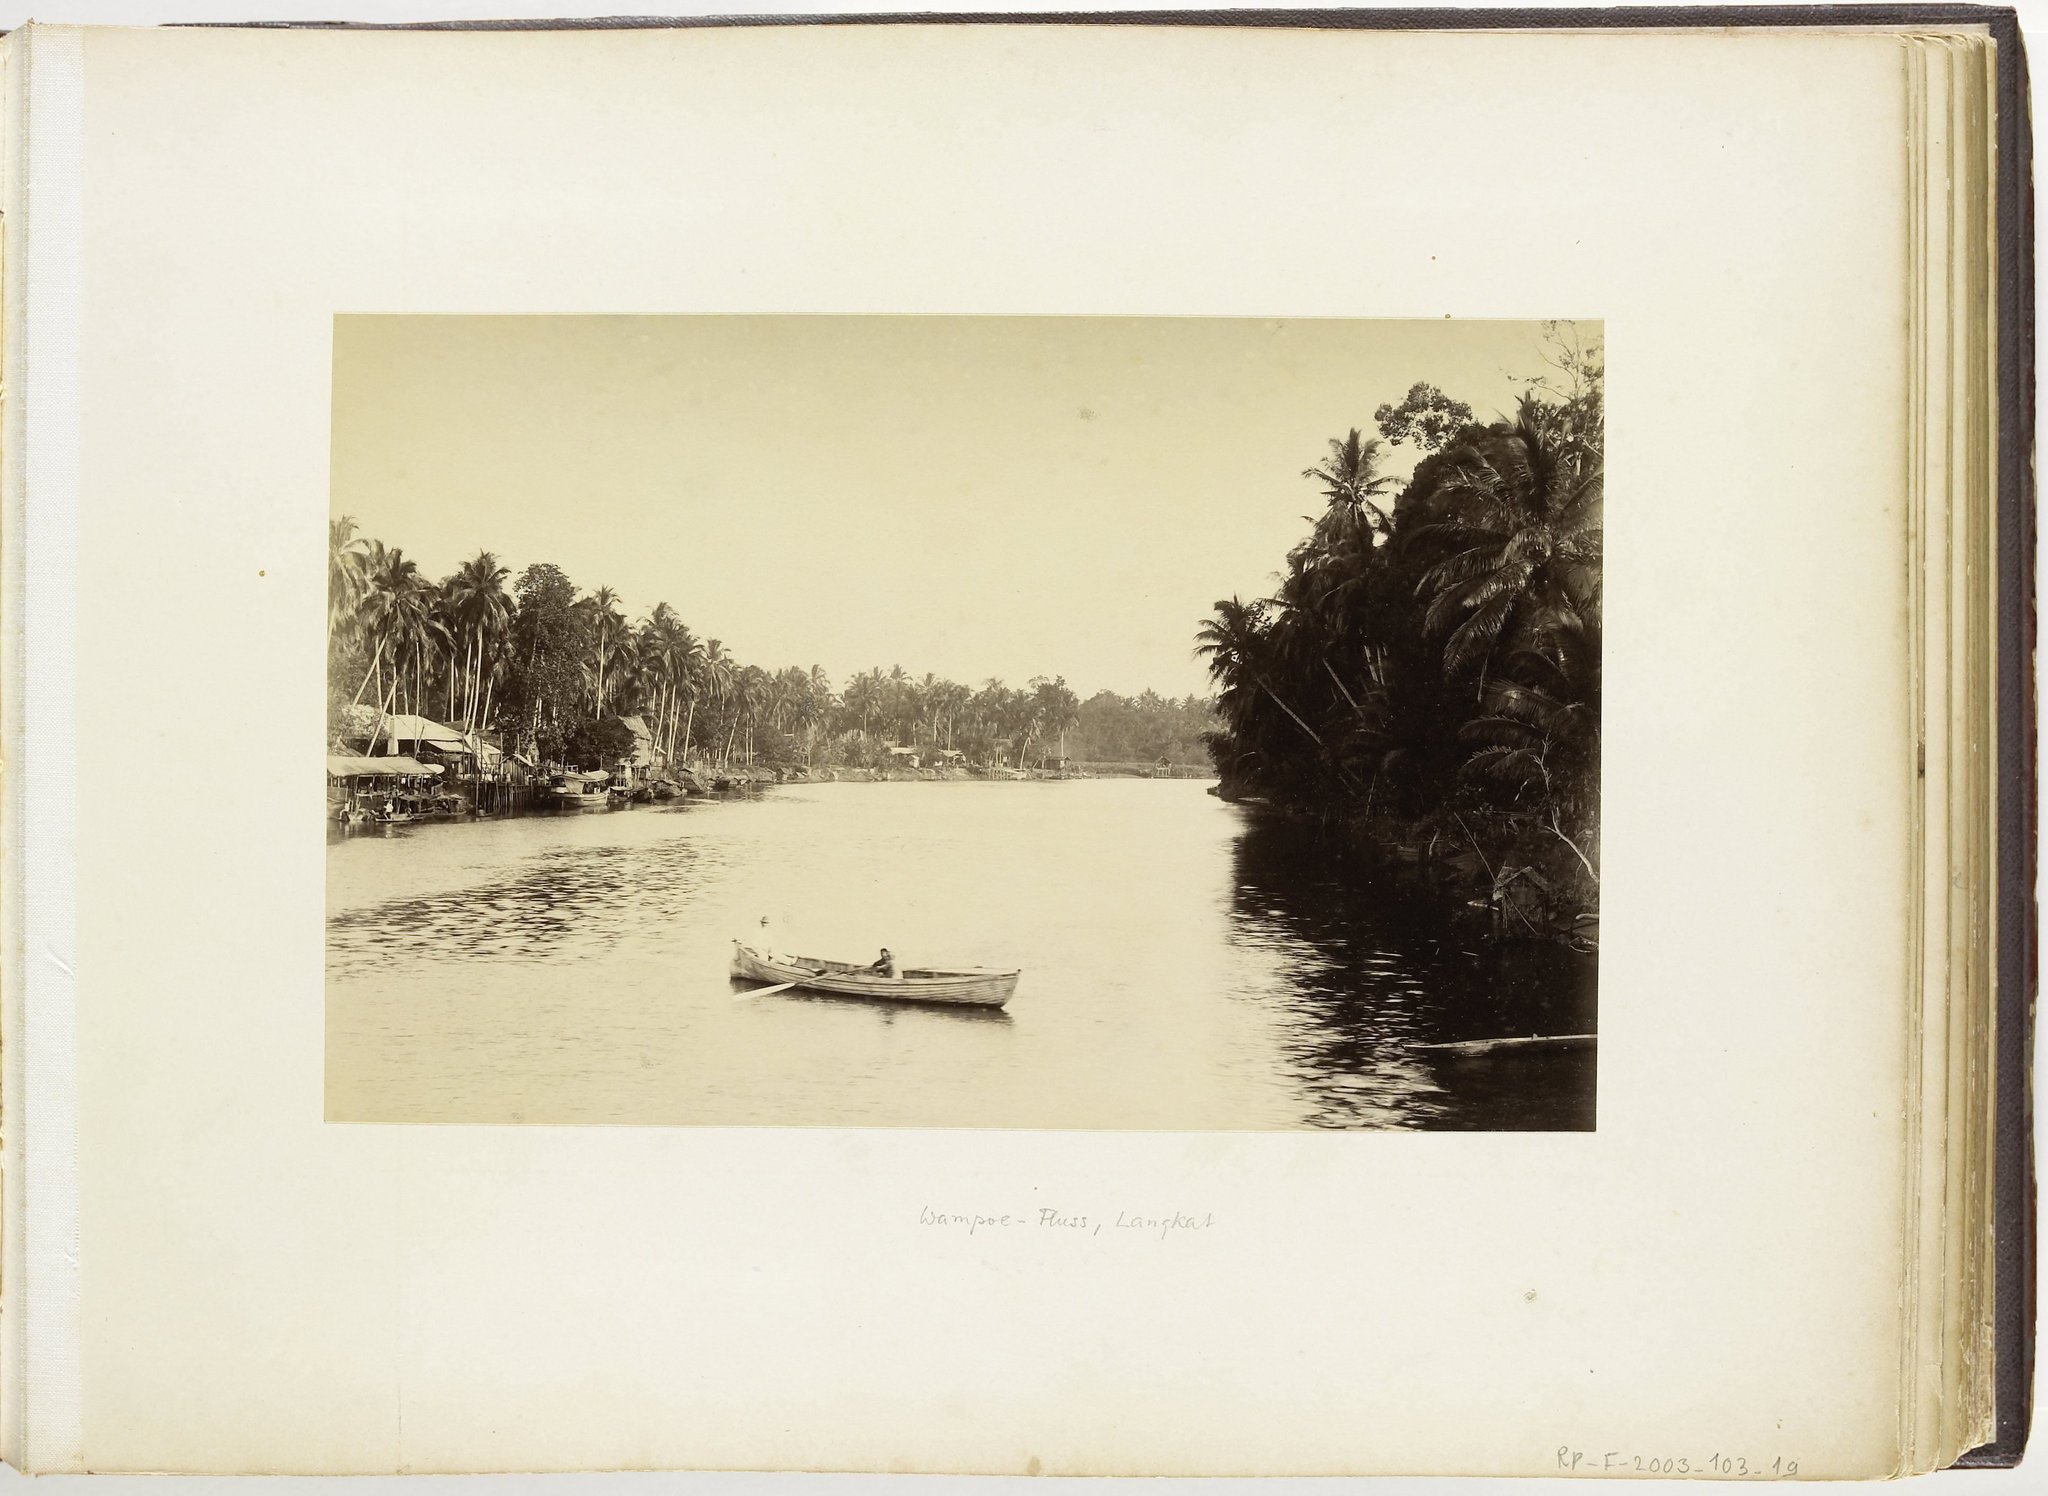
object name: photograph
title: Gezicht op de Wampoe rivier, Tandjong Poera, Langkat Sumatra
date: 1890-1900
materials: cardboard, paper, photographic support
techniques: albumen print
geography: bindjai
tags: tandjong poera